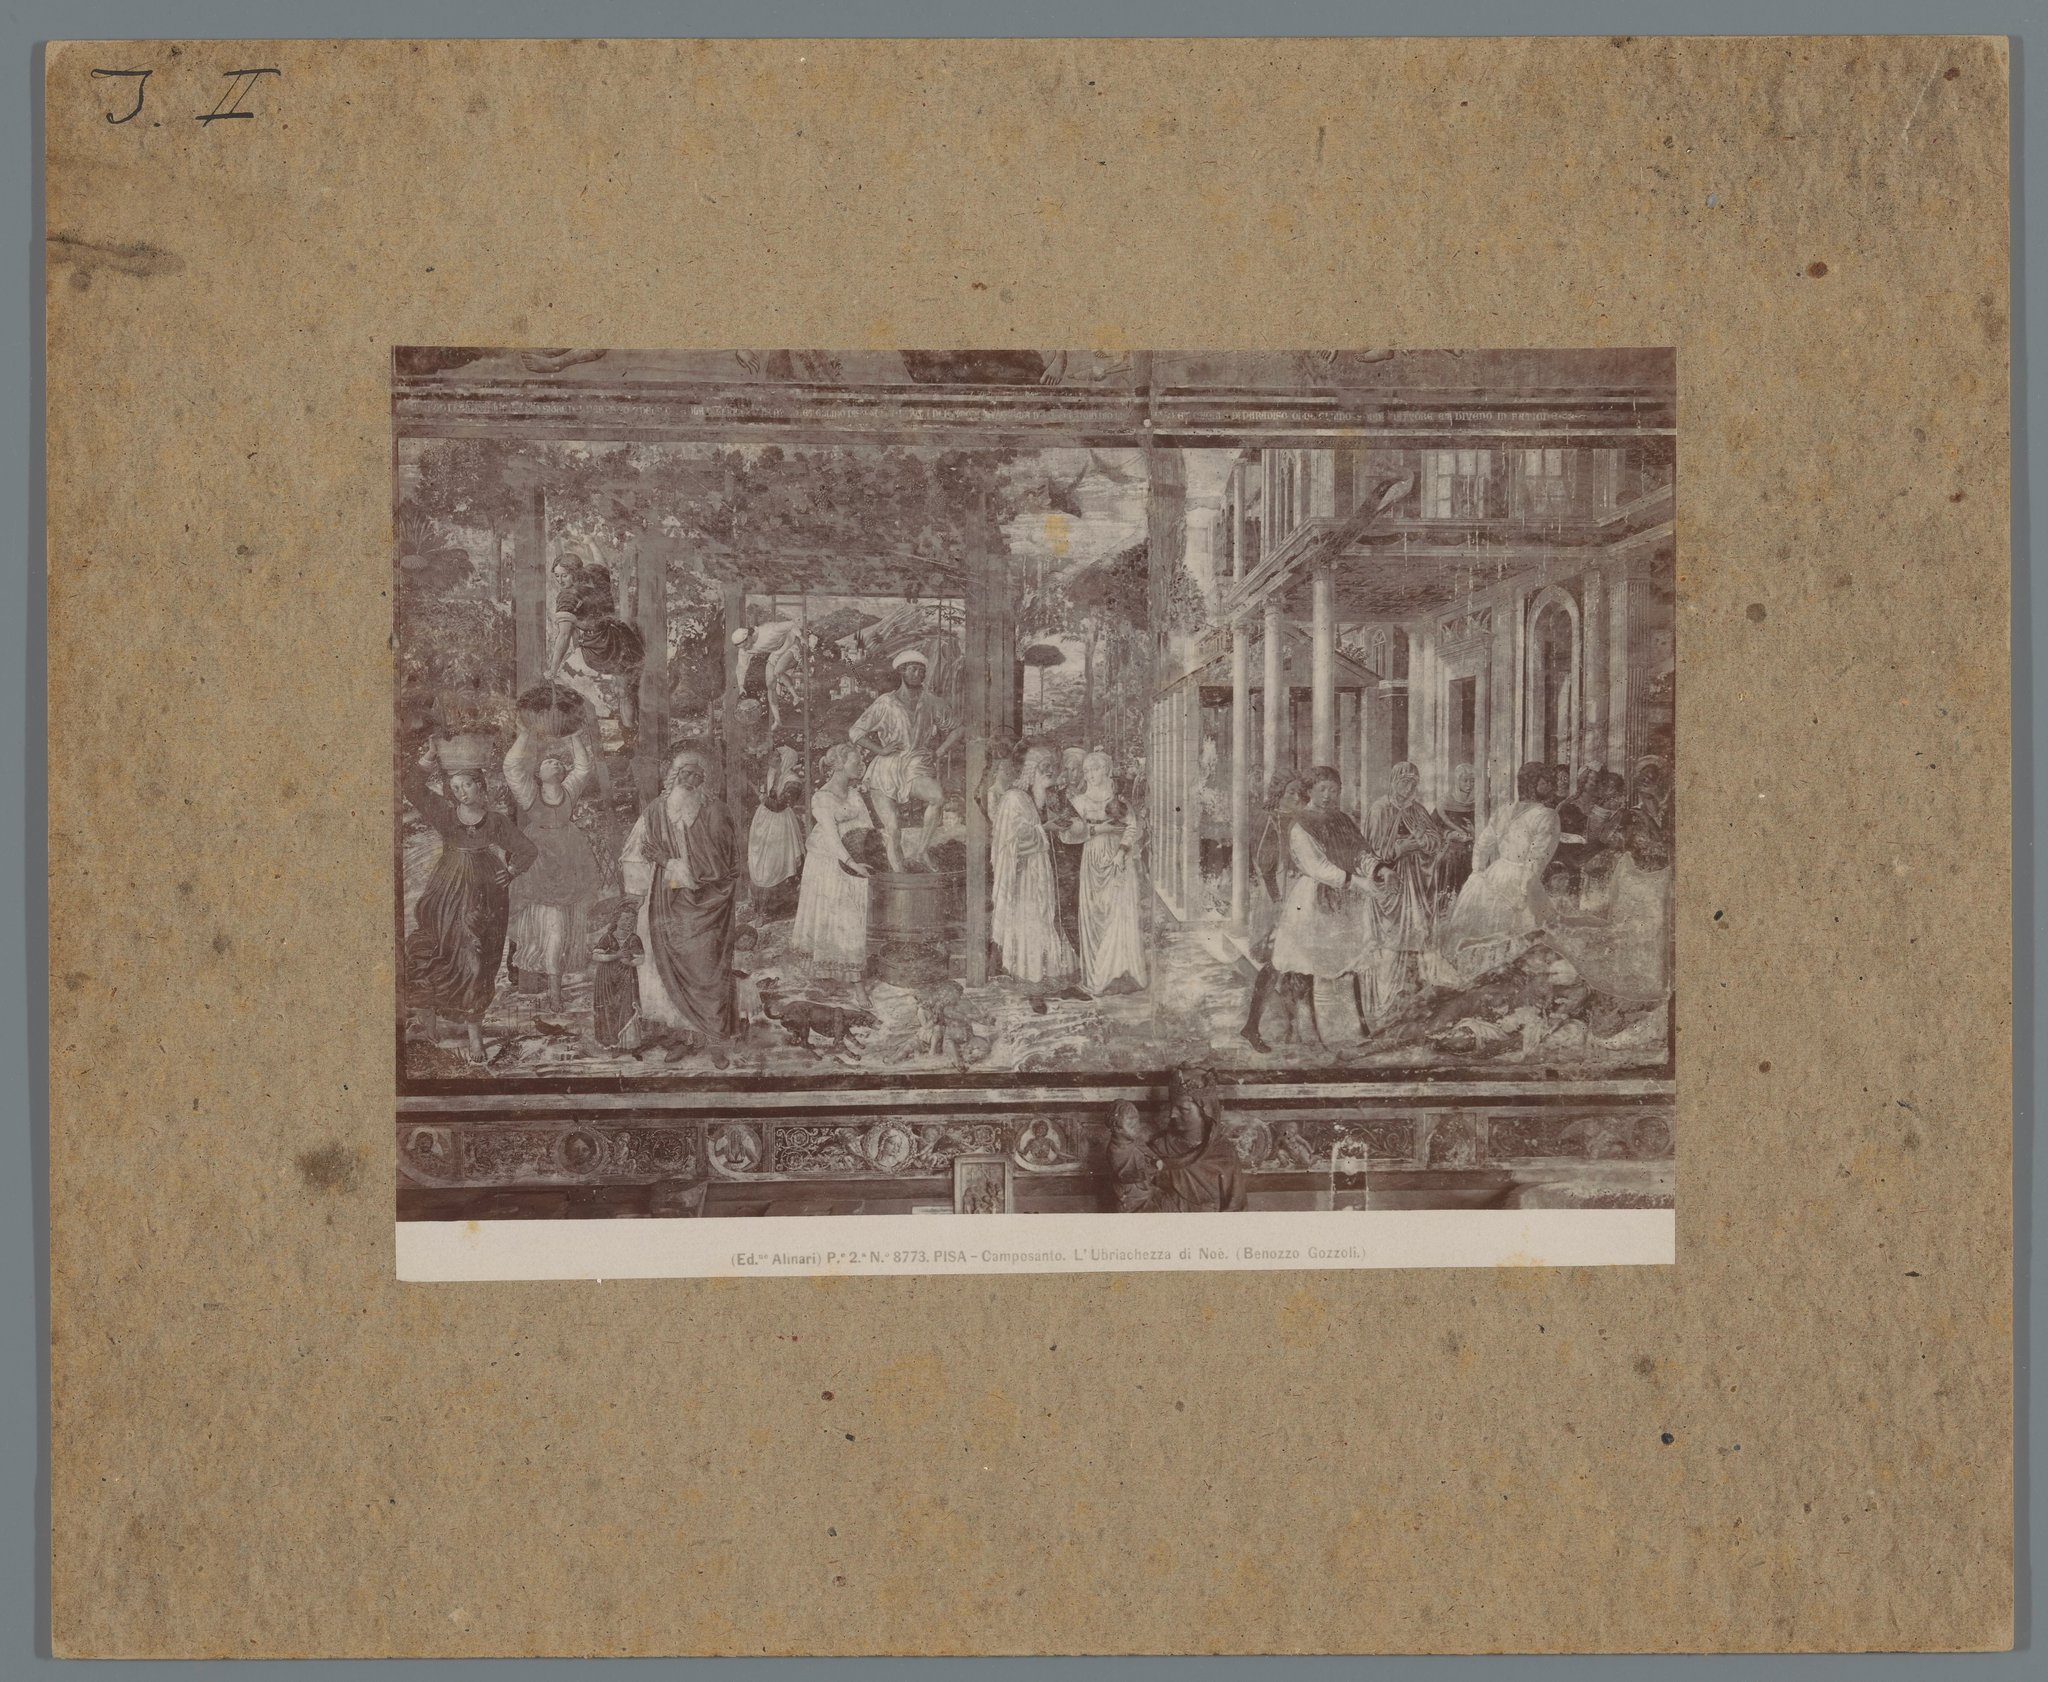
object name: reproduction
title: PISA - Camposanto. L'Ubriachezza di Noè.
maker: benozzo gozzoli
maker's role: draughtsman, painter, sculptor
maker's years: 1421-1497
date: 1875-1900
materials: cardboard, photographic support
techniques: albumen print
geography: pisa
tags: the drunkenness of noah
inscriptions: collector's mark: Lugt 3937, number: ‘P.e 2.a N.o 8773.’